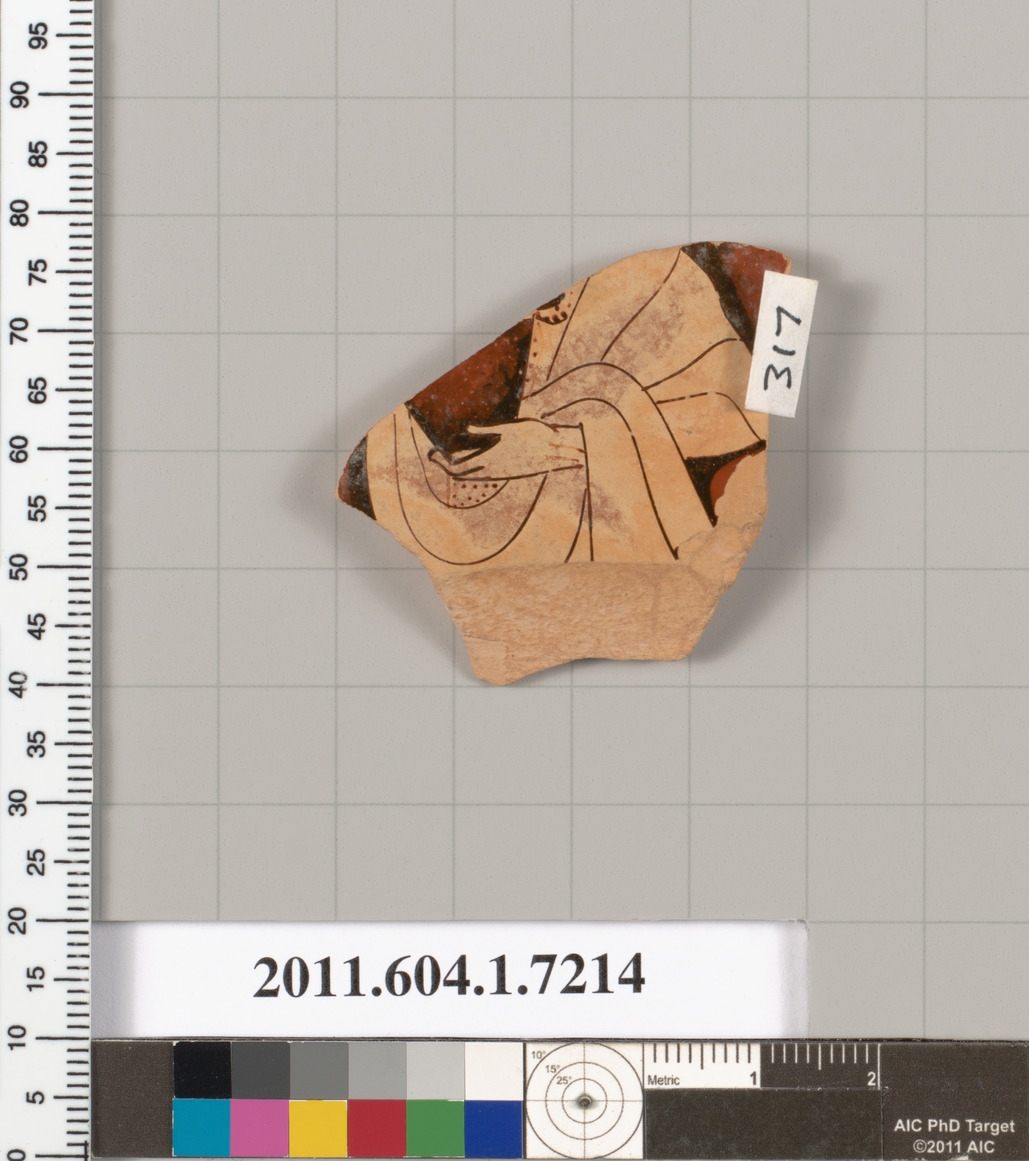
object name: kylix fragment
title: Terracotta fragment of a kylix (drinking cup)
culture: greek, attic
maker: makron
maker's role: artist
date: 500-480 BCE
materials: terracotta